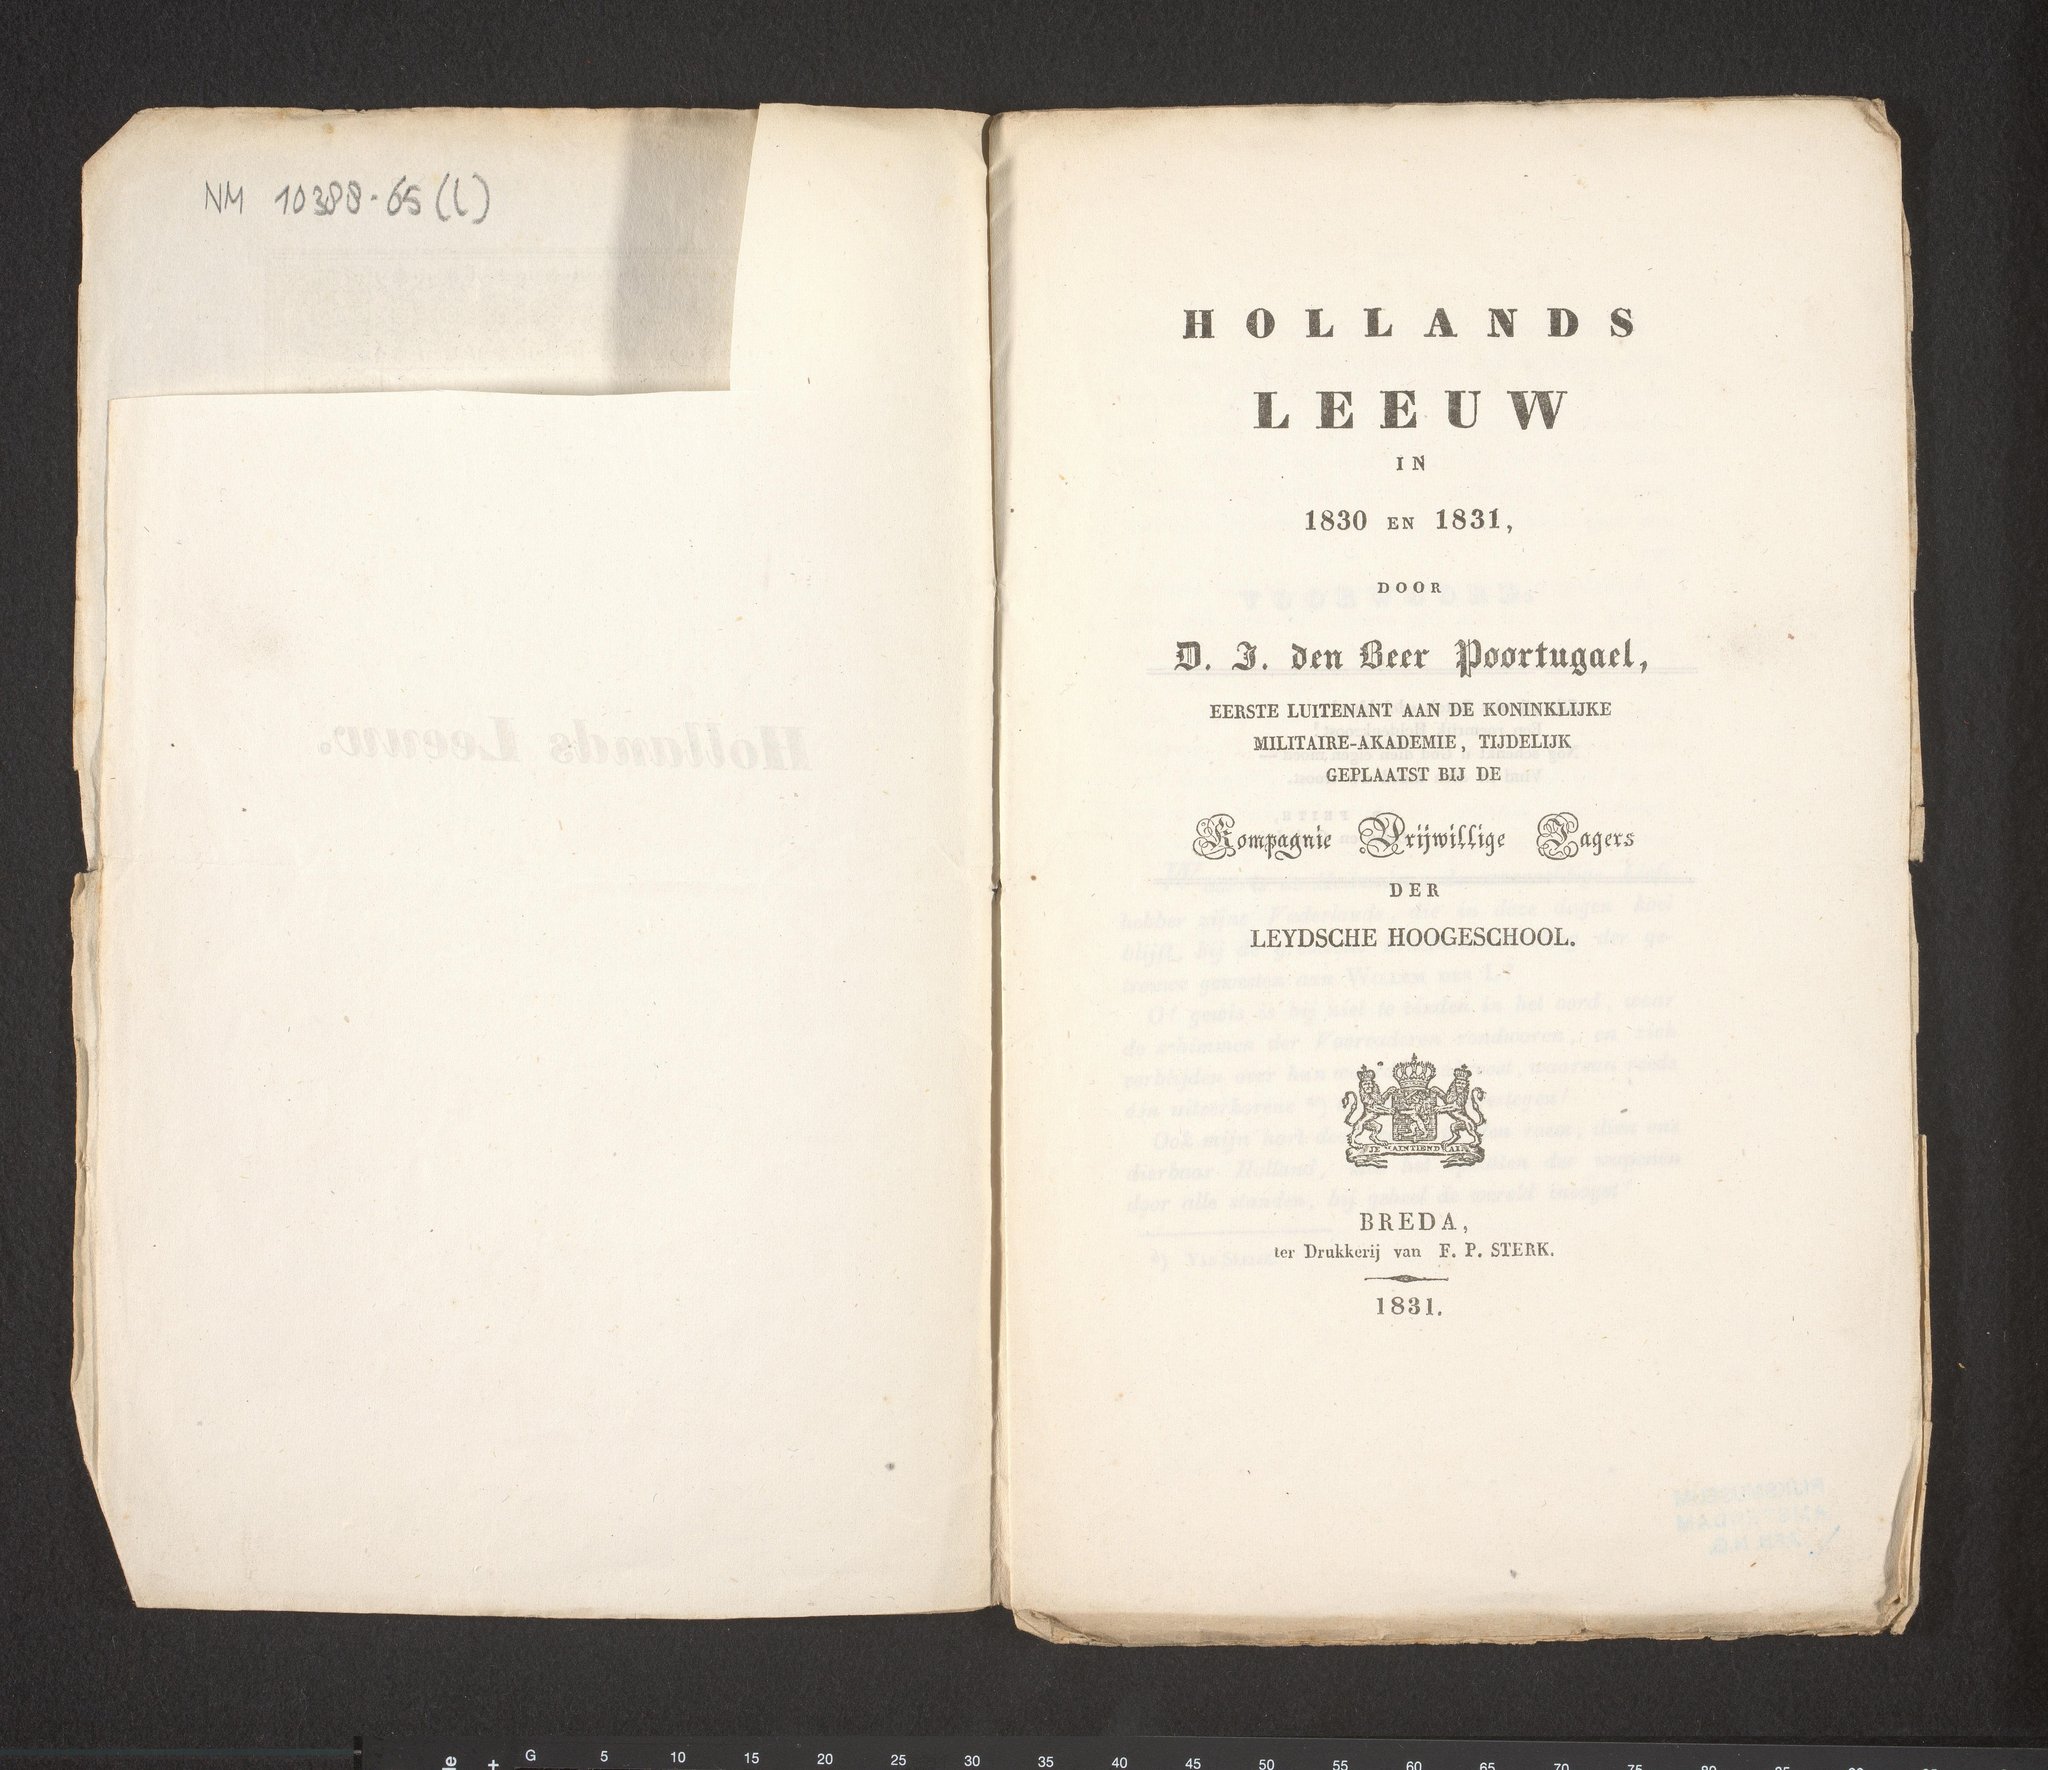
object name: brochure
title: Hollands Leeuw in 1830 en 1831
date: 1831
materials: paper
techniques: printing, sewing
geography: breda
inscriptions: date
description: 10 pp in papieren omslag. Gedateerd; titelp.: 1831